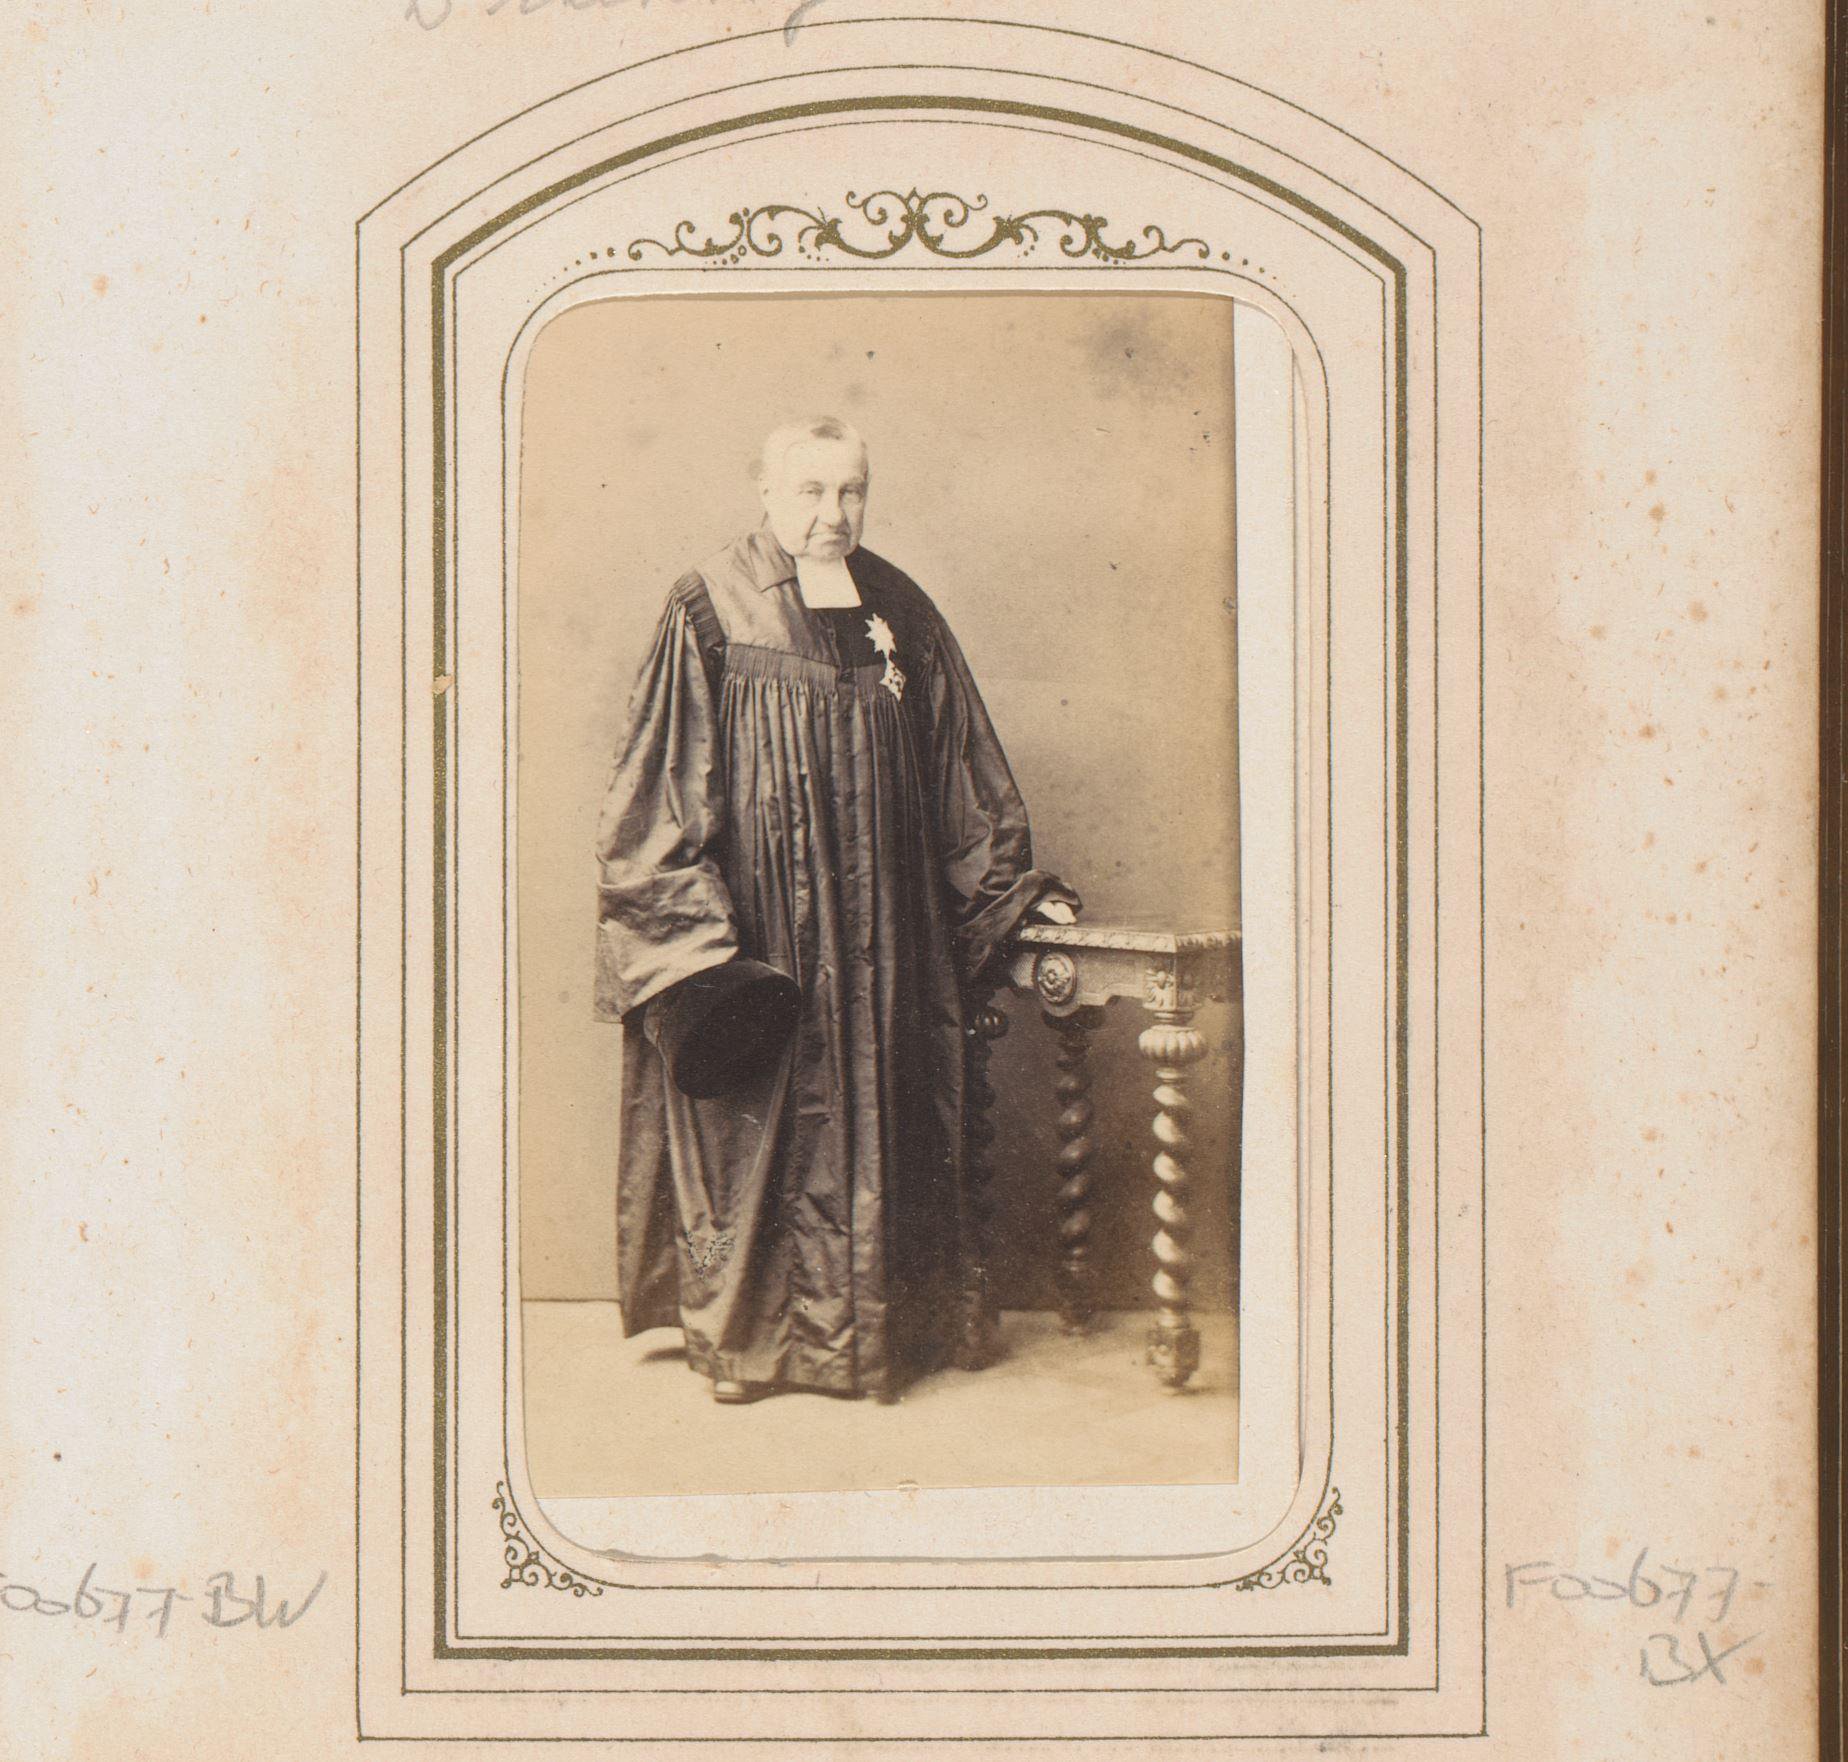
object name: album leaf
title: Portret van een onbekende geestelijke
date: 1850-1870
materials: cardboard, photographic support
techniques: albumen print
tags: theologian, historical persons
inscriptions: inscription: ‘L. Haase & Comp. in Berlin,/ Königl. Hof-Photographen/ und Hof-Photographen Ihrer Kgl. Hoheit der Frau/ Kronprinzessin v. Preussen./ 178. Grosse Friedrich-Strasse 178.’